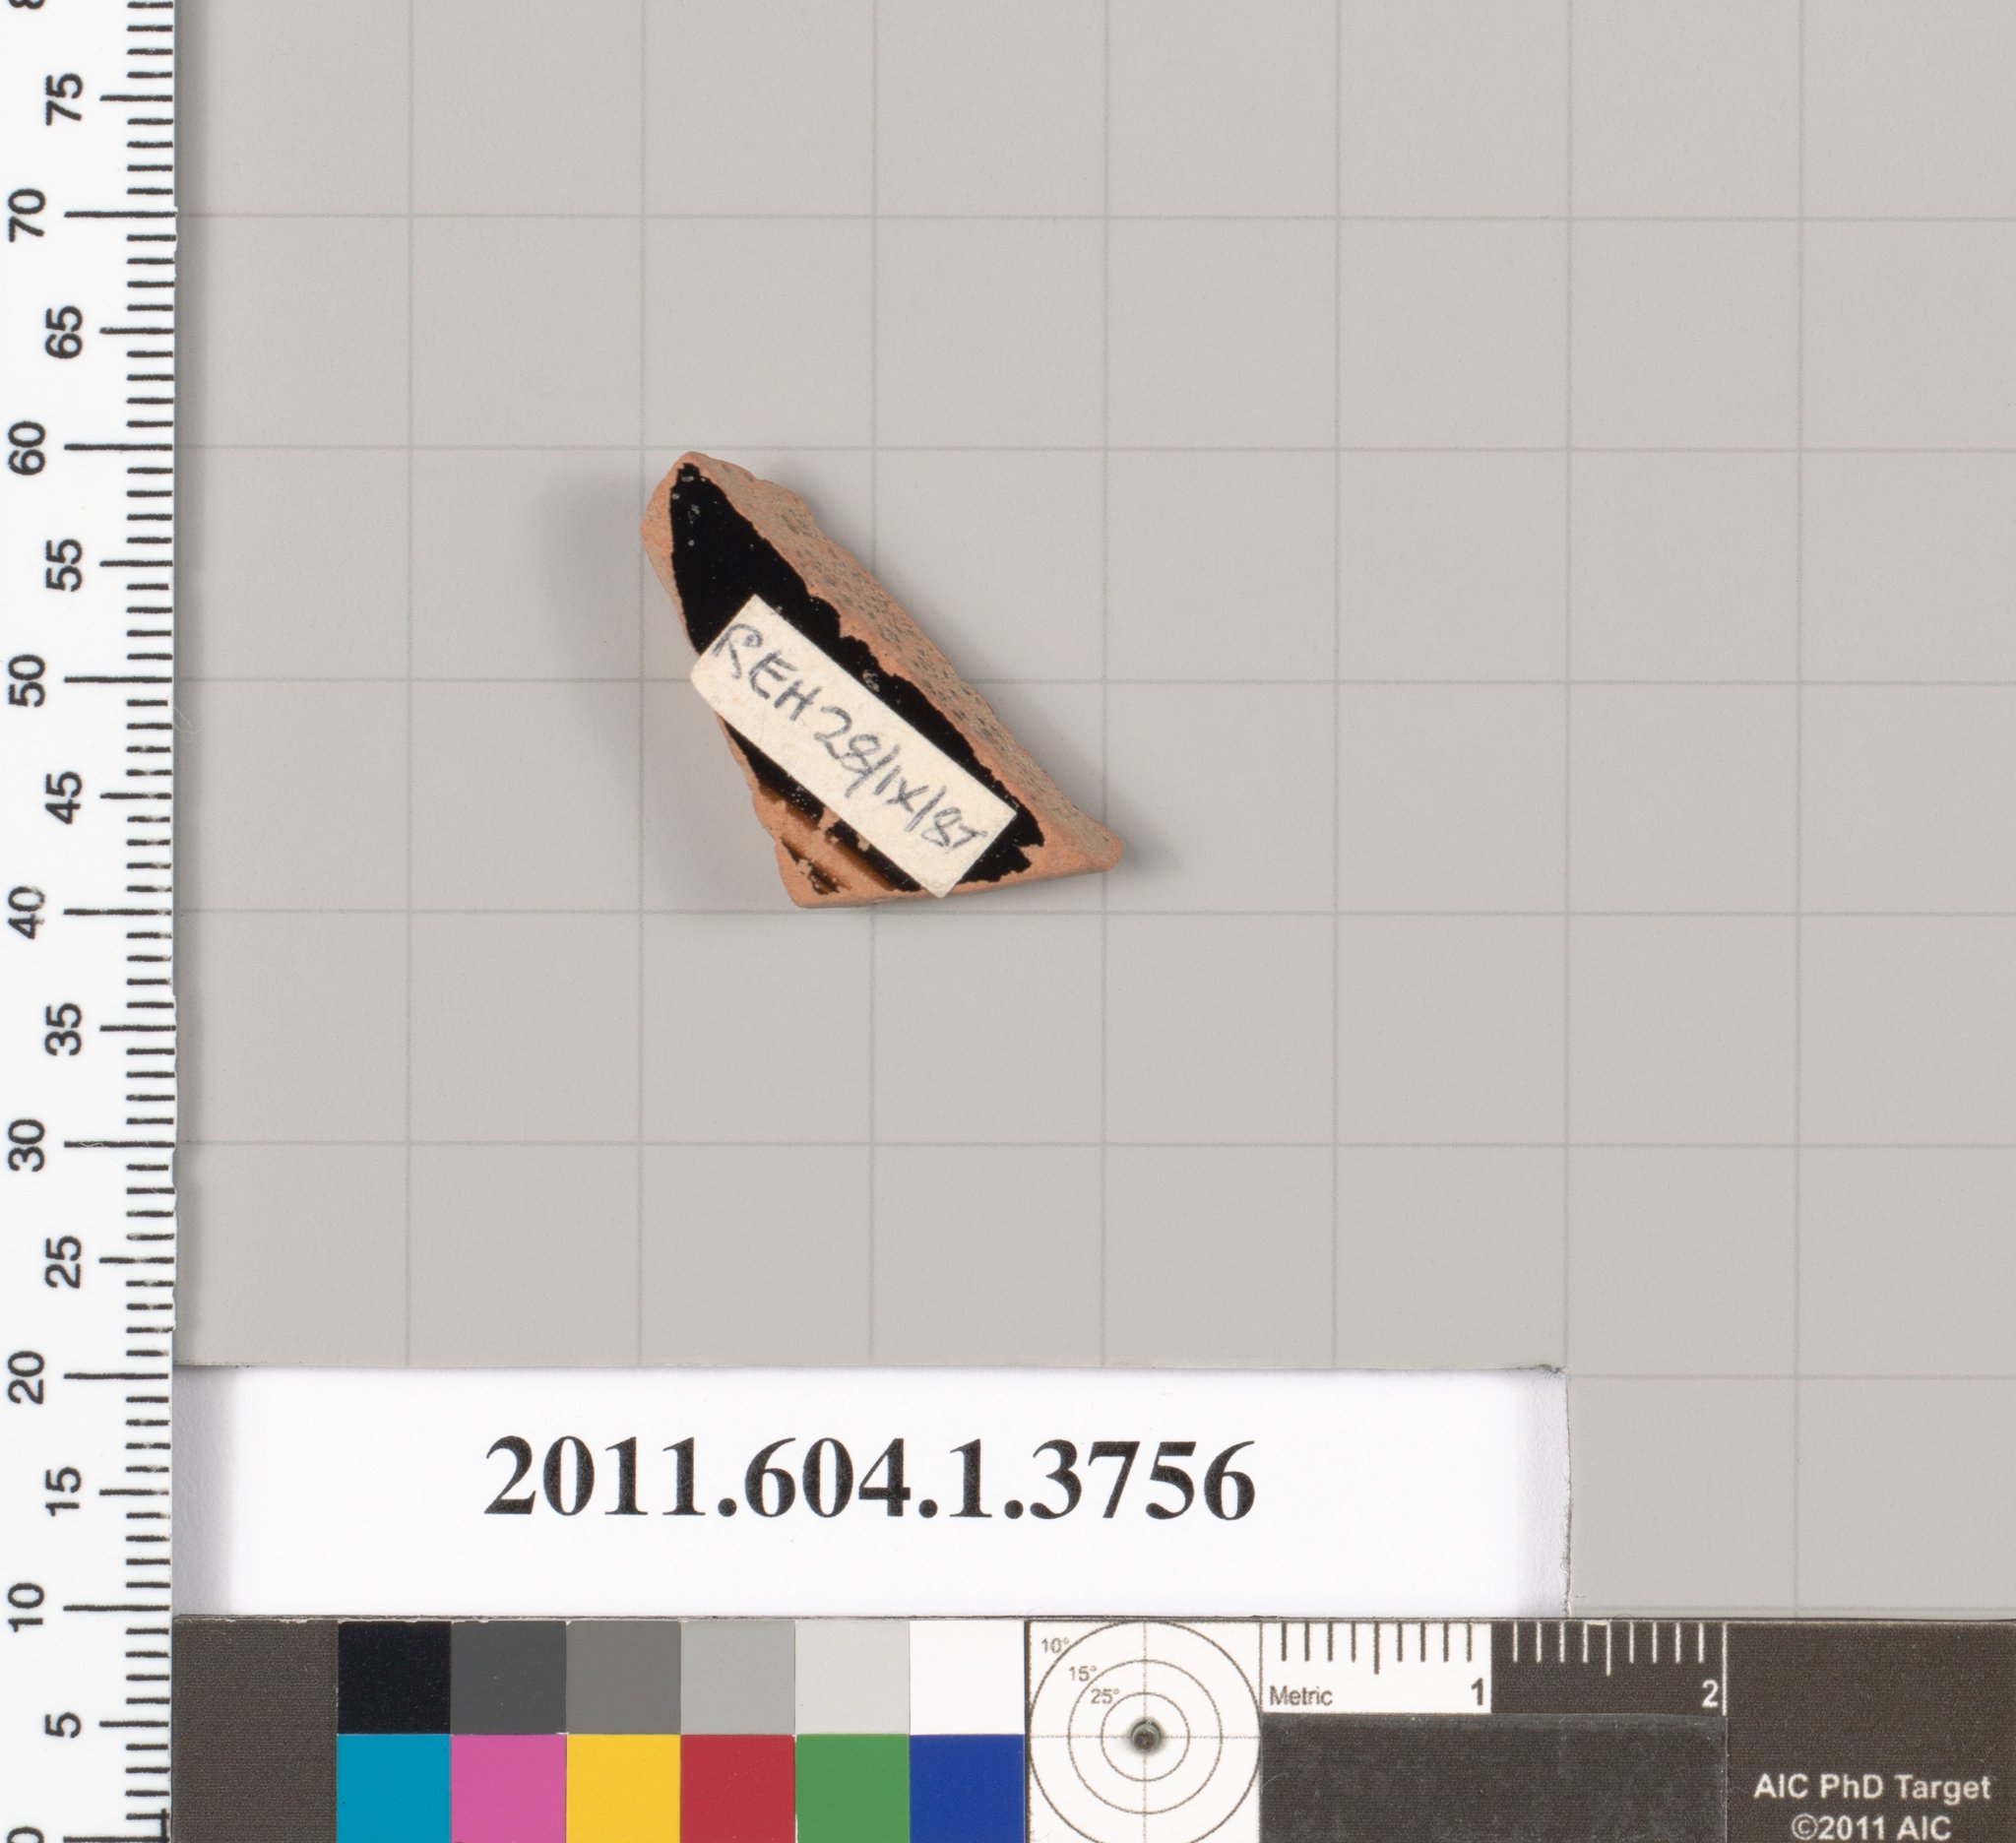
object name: kylix fragment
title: Terracotta fragment of a kylix (drinking cup)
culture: greek, attic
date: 475-451 BCE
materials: terracotta